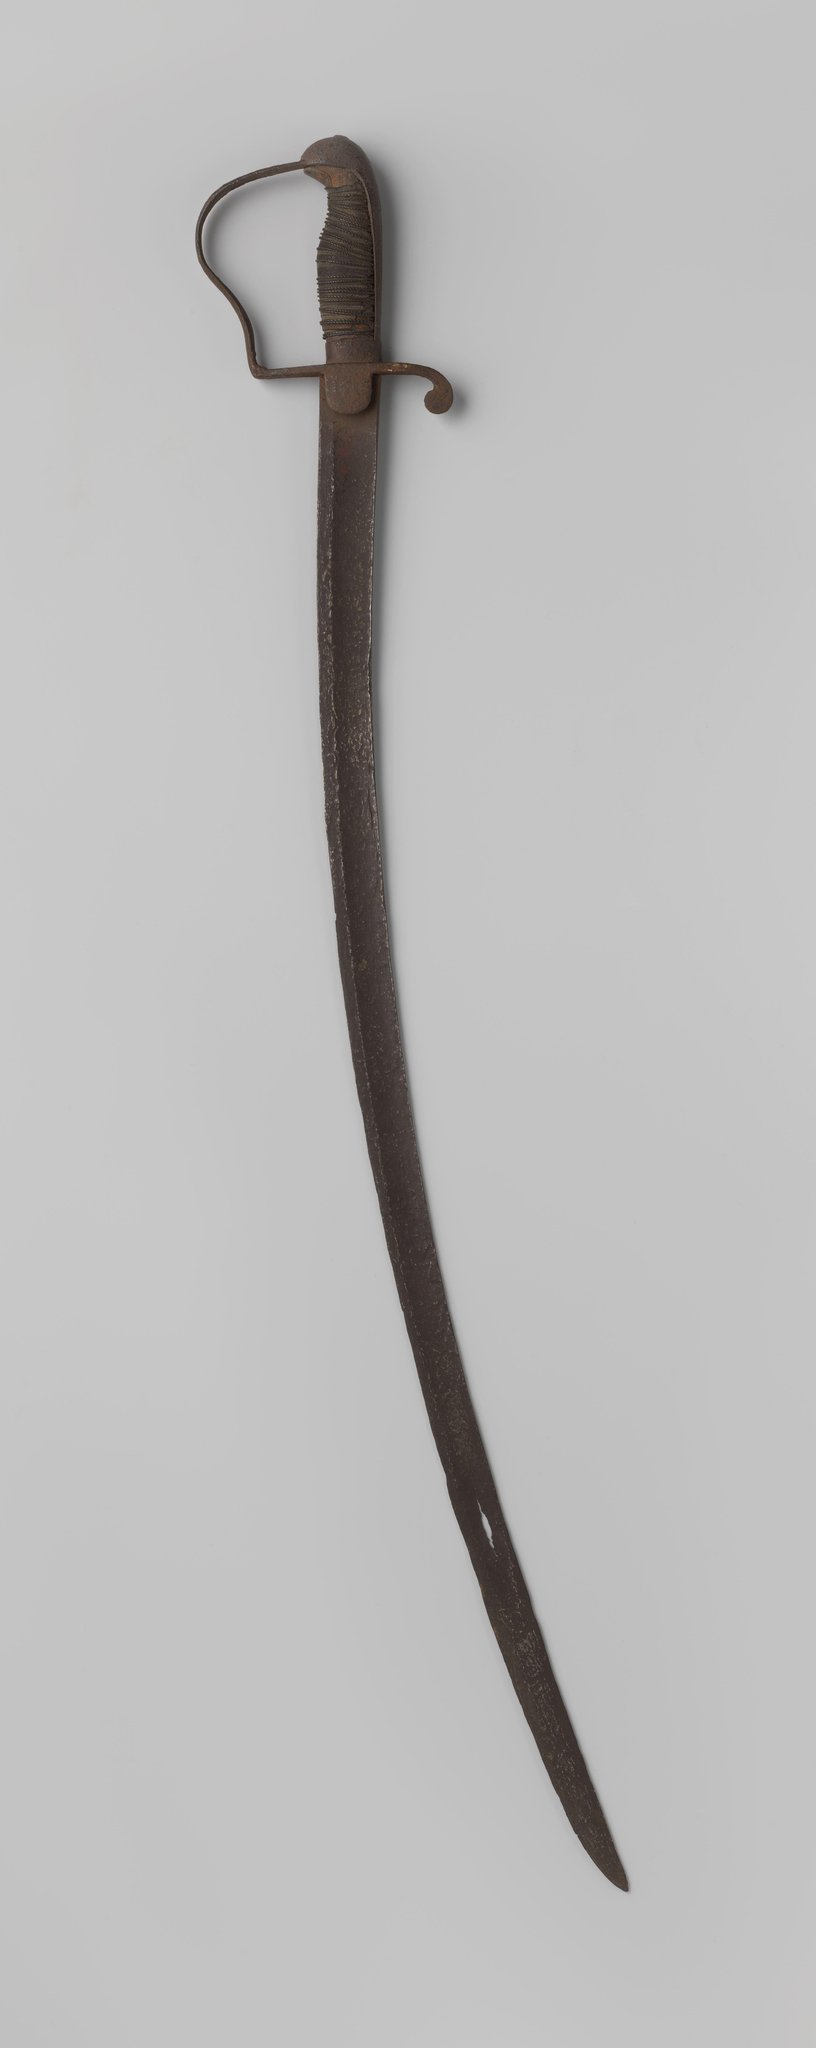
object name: sabre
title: Sabel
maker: Anonymous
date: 1700-1950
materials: iron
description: Sabel met gebogen kling en met draad omwoelde greep.